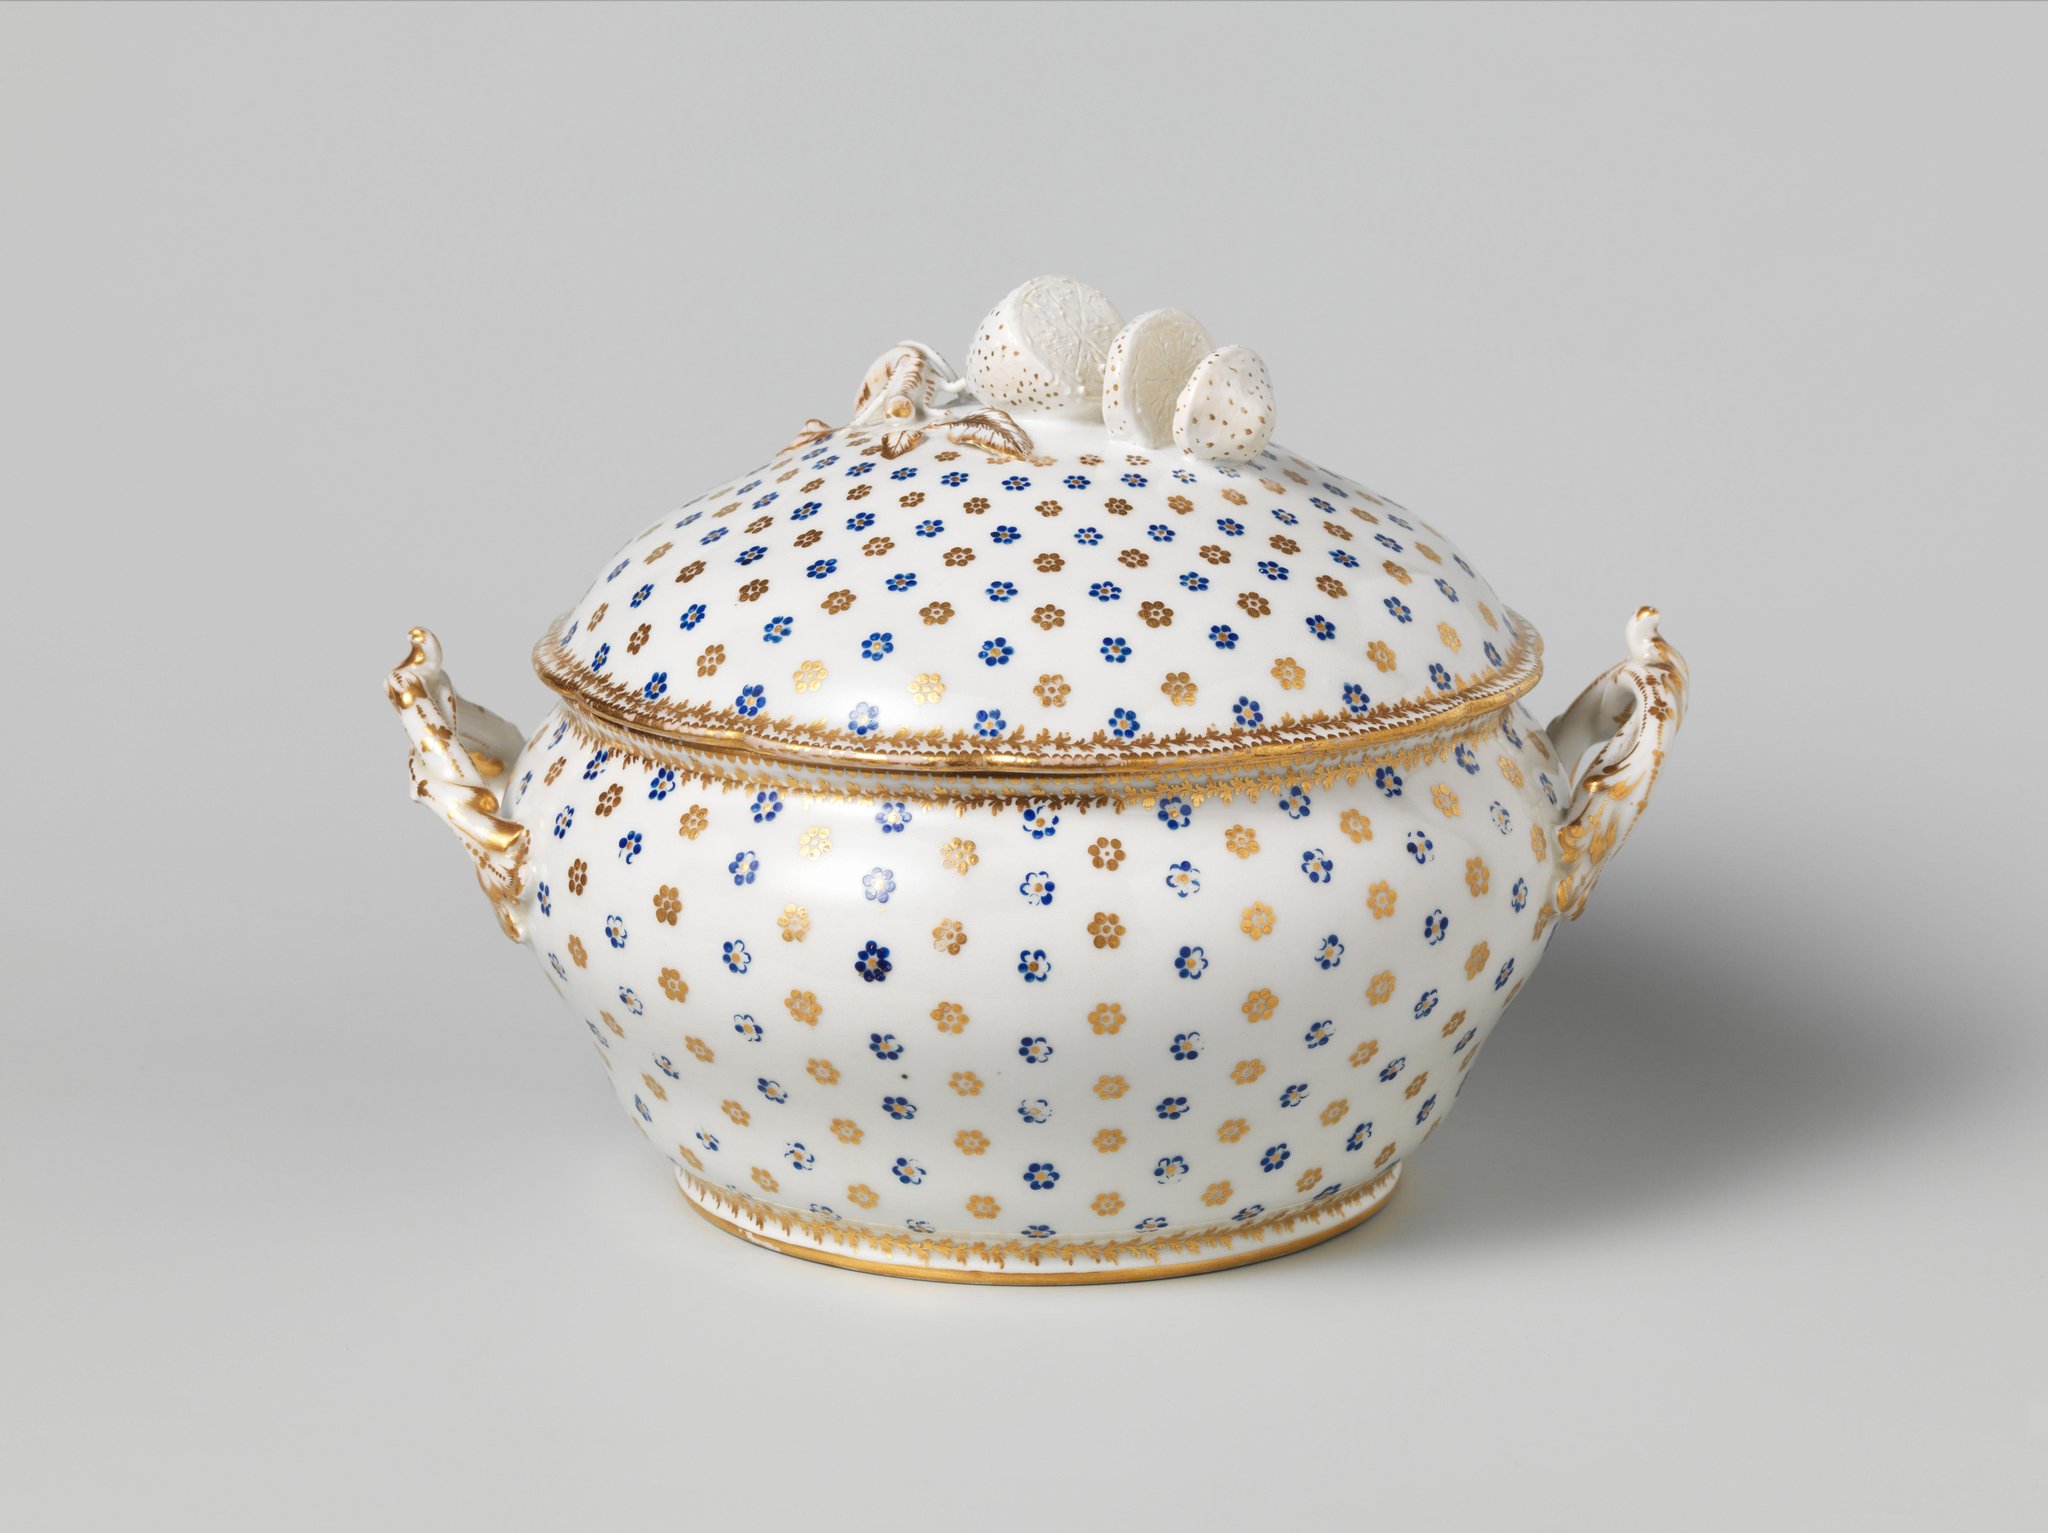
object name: tureen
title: Deksel van terrine, beschilderd met een regelmatig strooipatroon van rozetten in blauw en goud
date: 1778-1782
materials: porcelain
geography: loosdrecht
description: Deksel van porselein. De dekselrand geschulpt, een vrucht aan een tak met bladeren als knop. Beschilderd met een regelmatig strooipatroon van rozetten afwisselend in blauw en goud. Langs voet-, mond- en dekselrand van de terrine een bladslinger in goud naast een gouden bies met afhangend bladwerk. Oren en knop versierd met ornament in goud.